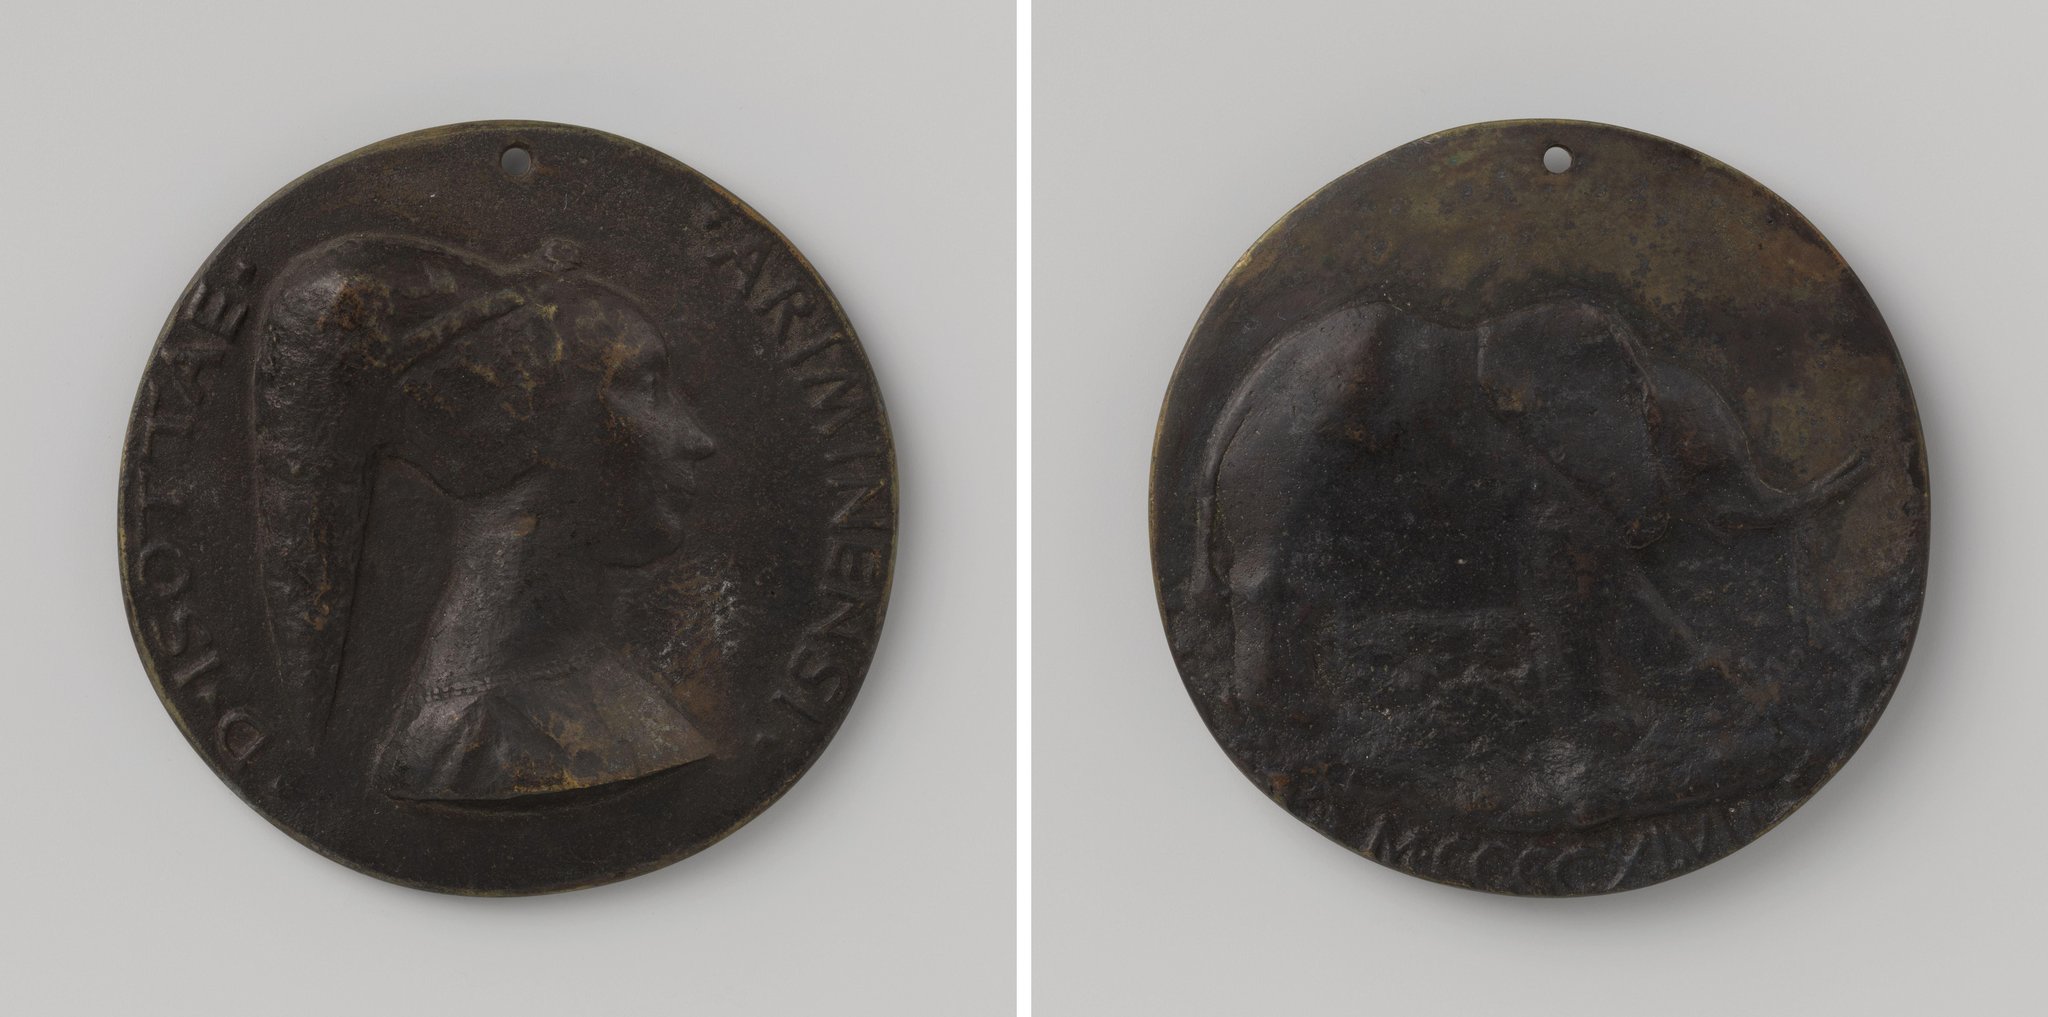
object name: history medal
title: Isotta Atti, vierde vrouw van Sigismondo Pandolfo Malatesta, heer van Rimini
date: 1446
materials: bronze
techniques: casting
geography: rimini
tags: militair, legeraanvoerder, sigismondo pandolfo malatesta, isotta atti, rimini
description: Bronzen penning met gat. Voorzijde: borststuk vrouw met puntmuts binnen omschrift. Keerzijde: olifant boven opschrift.